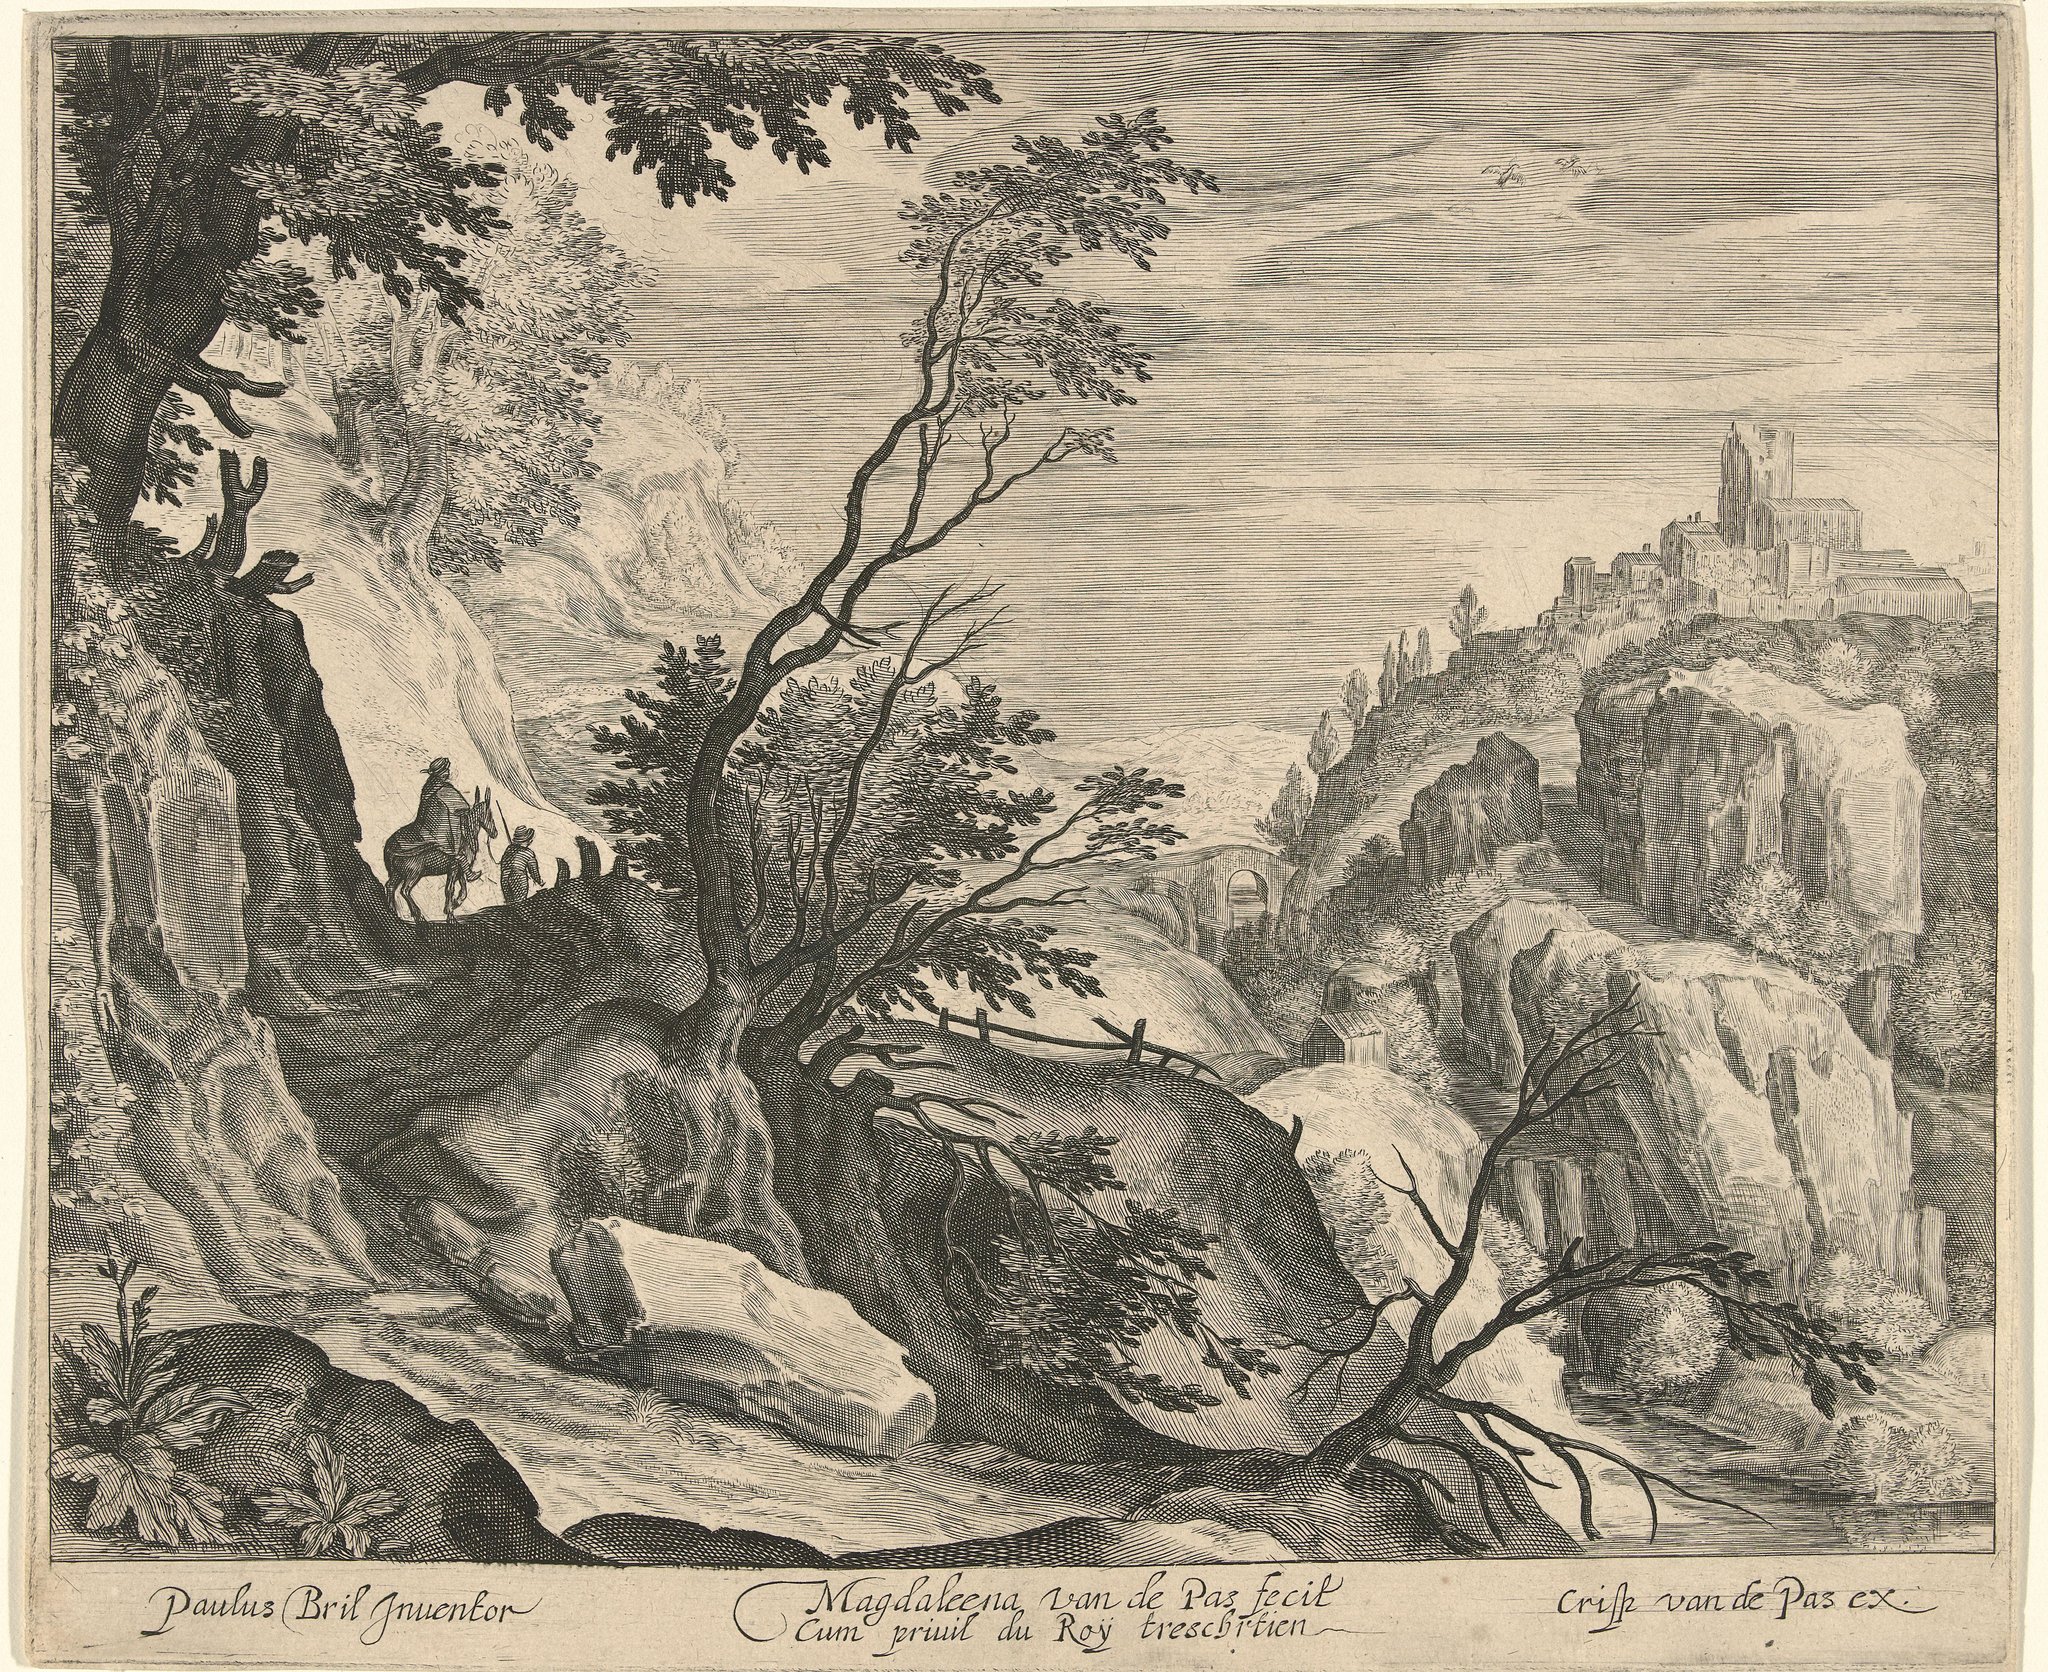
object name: print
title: Landschappen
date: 1617-1634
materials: paper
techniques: engraving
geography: utrecht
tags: ass, donkey, landscapes (+ landscape with figures, staffage)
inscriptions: collector's mark: Lugt 2228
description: Bergachtig landschap met grillige rotsen. Links een pad met twee reizigers en een ezel.